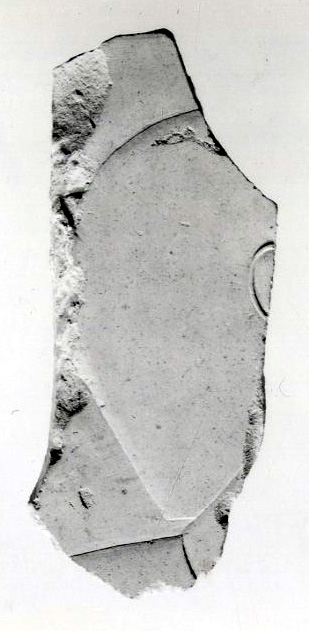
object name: relief fragment, tomb of meketre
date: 1981-1975 BCE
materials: limestone, paint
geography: egypt